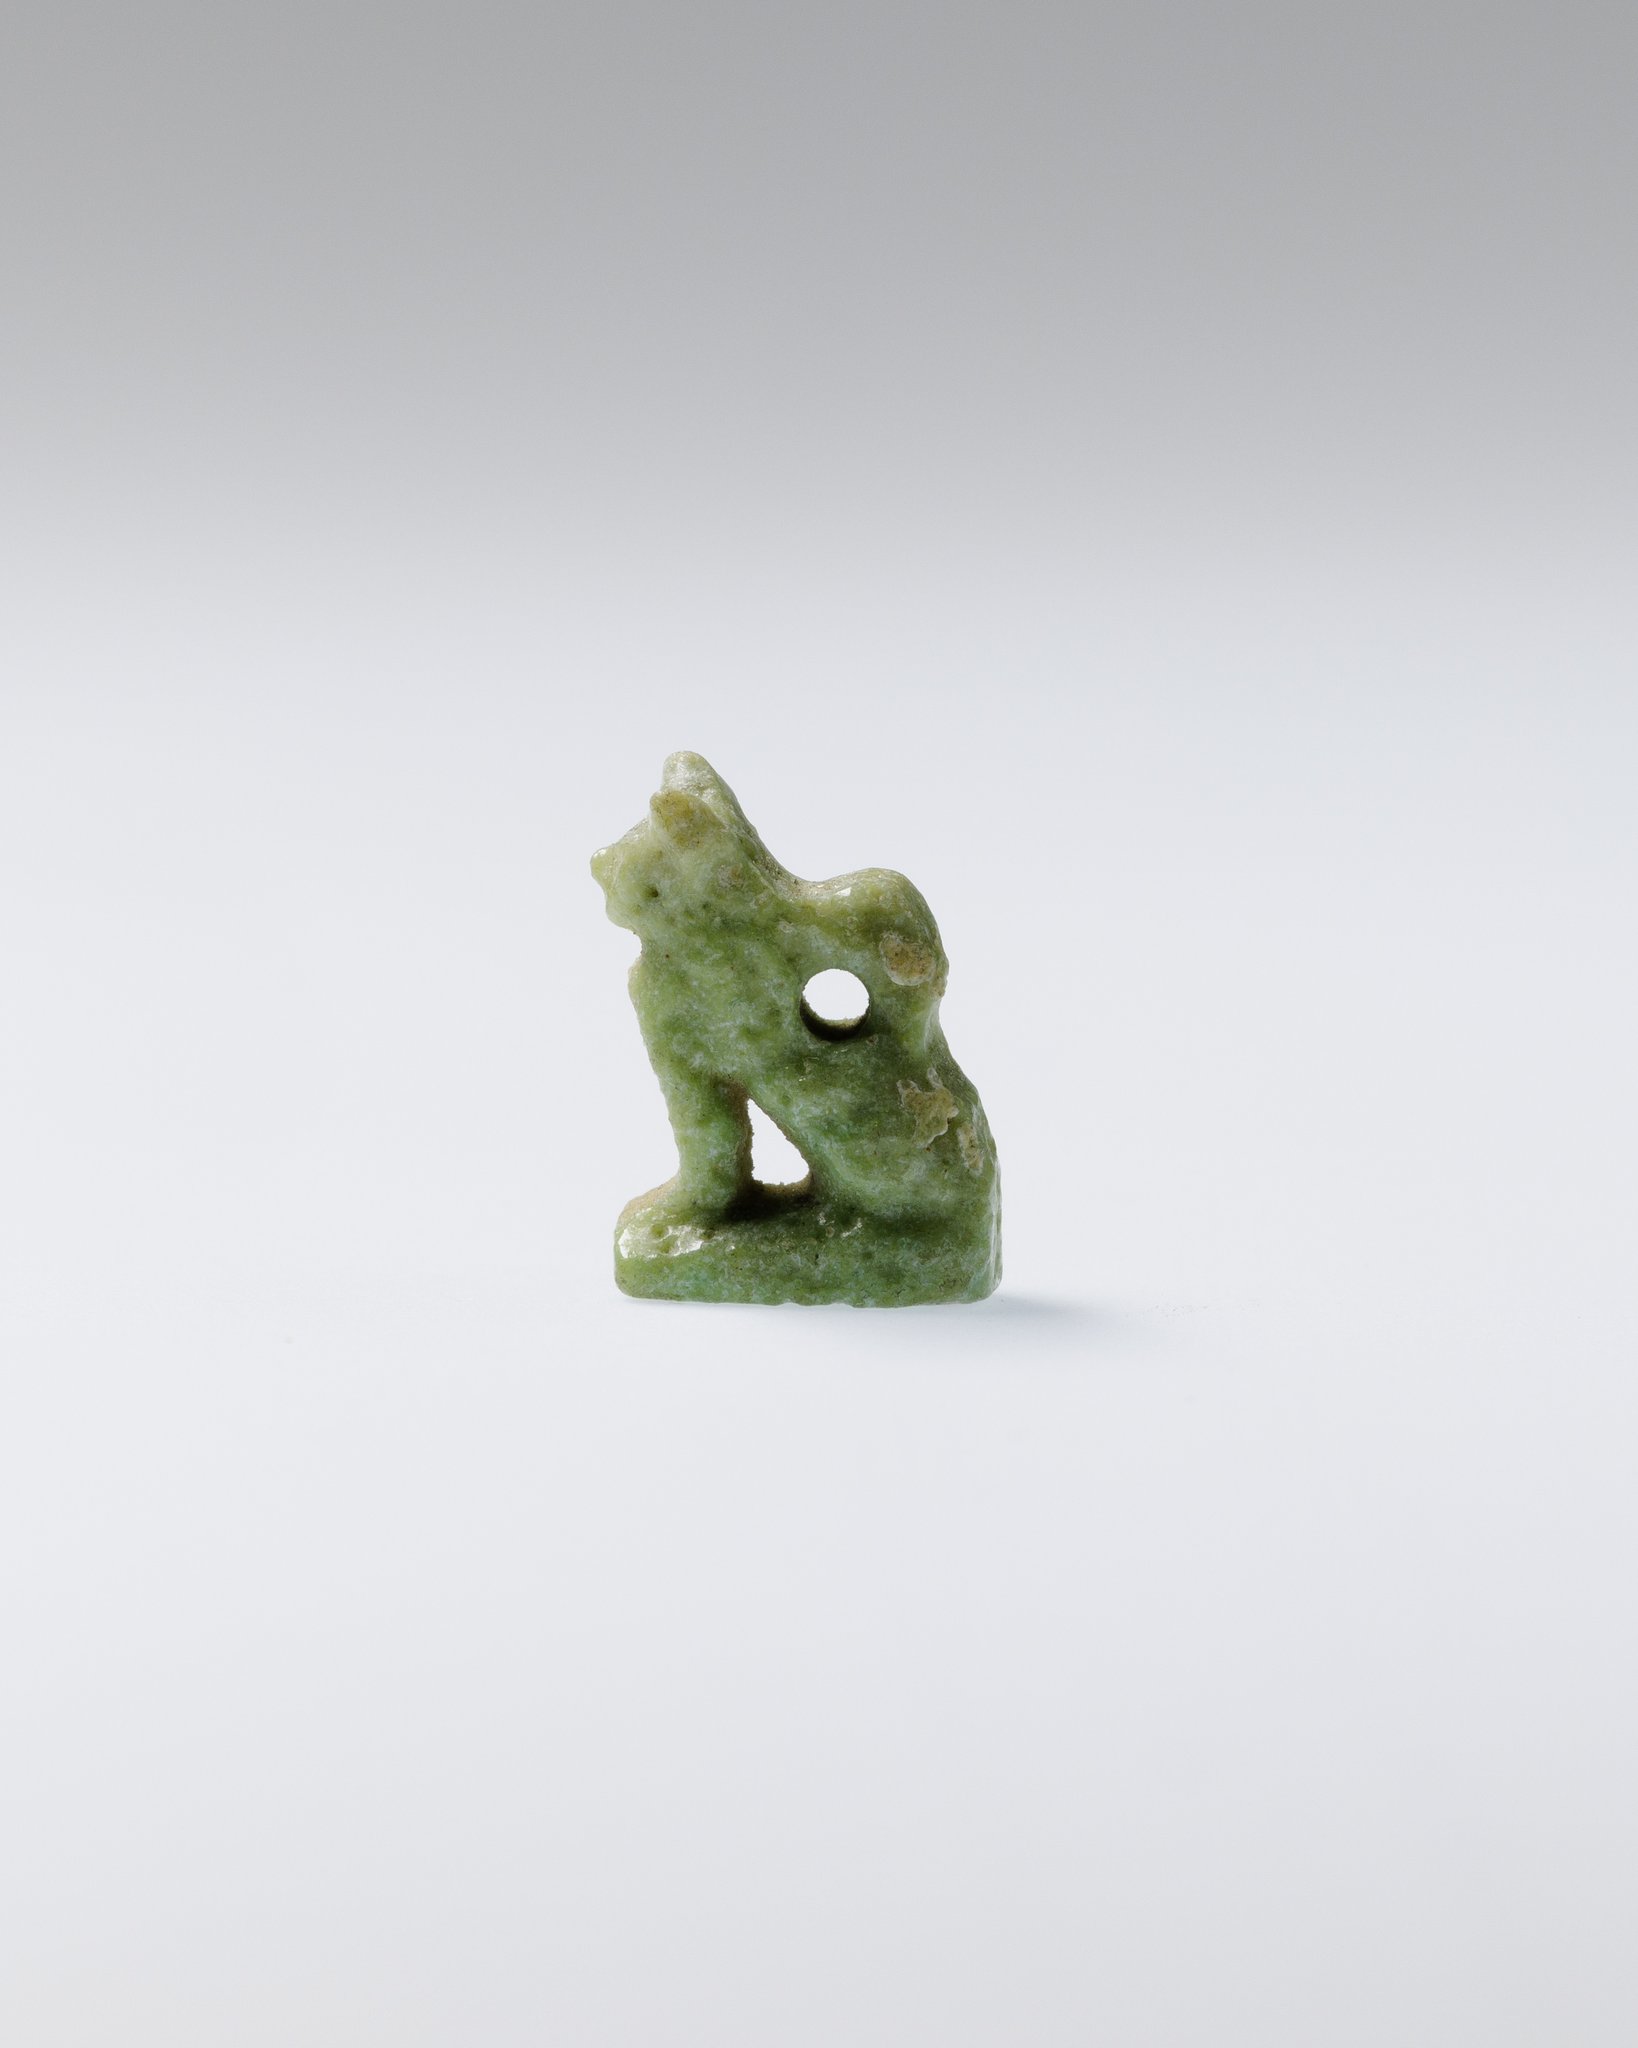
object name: amulet, cat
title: Cat amulet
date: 664-630 BCE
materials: faience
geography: egypt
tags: cats